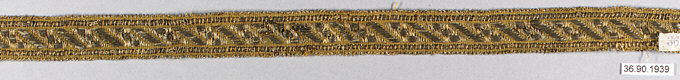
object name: galloon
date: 1801-1900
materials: metal thread, silk